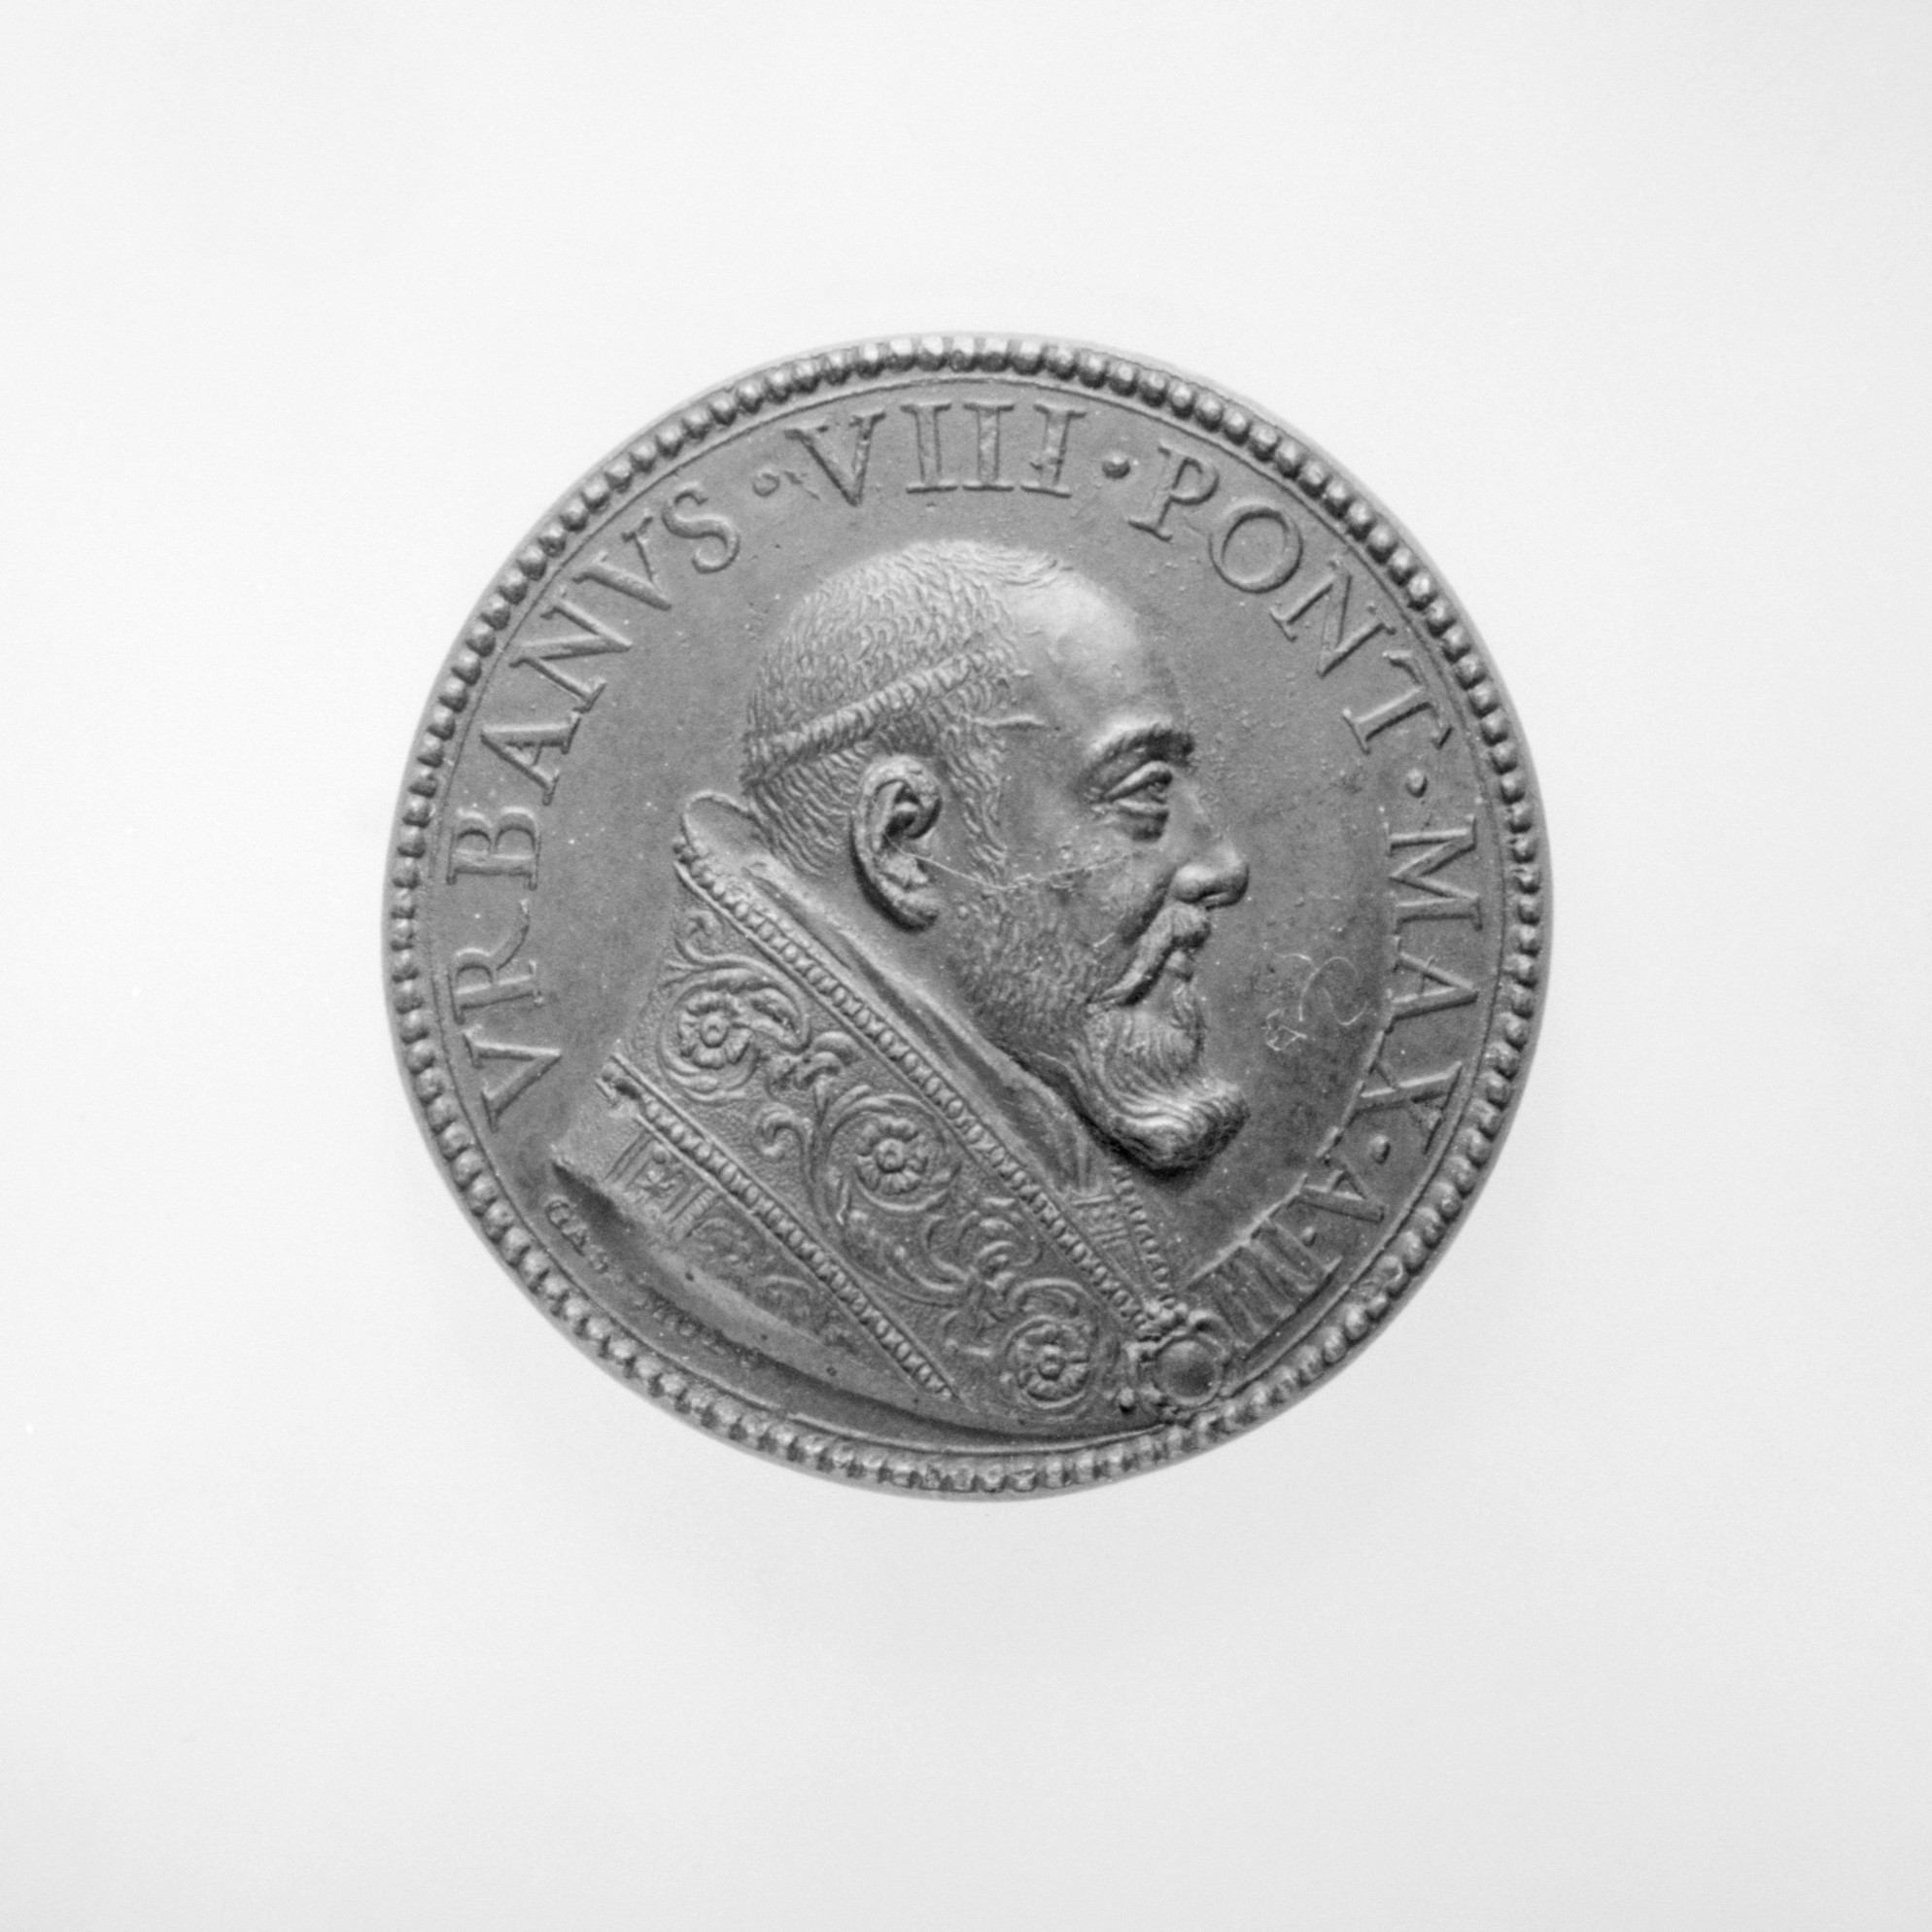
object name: medal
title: Urban VIII (Pope, 1623–44)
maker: gasparo mola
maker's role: artist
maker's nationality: italian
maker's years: 1575-1640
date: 1627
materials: bronze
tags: profiles,popes